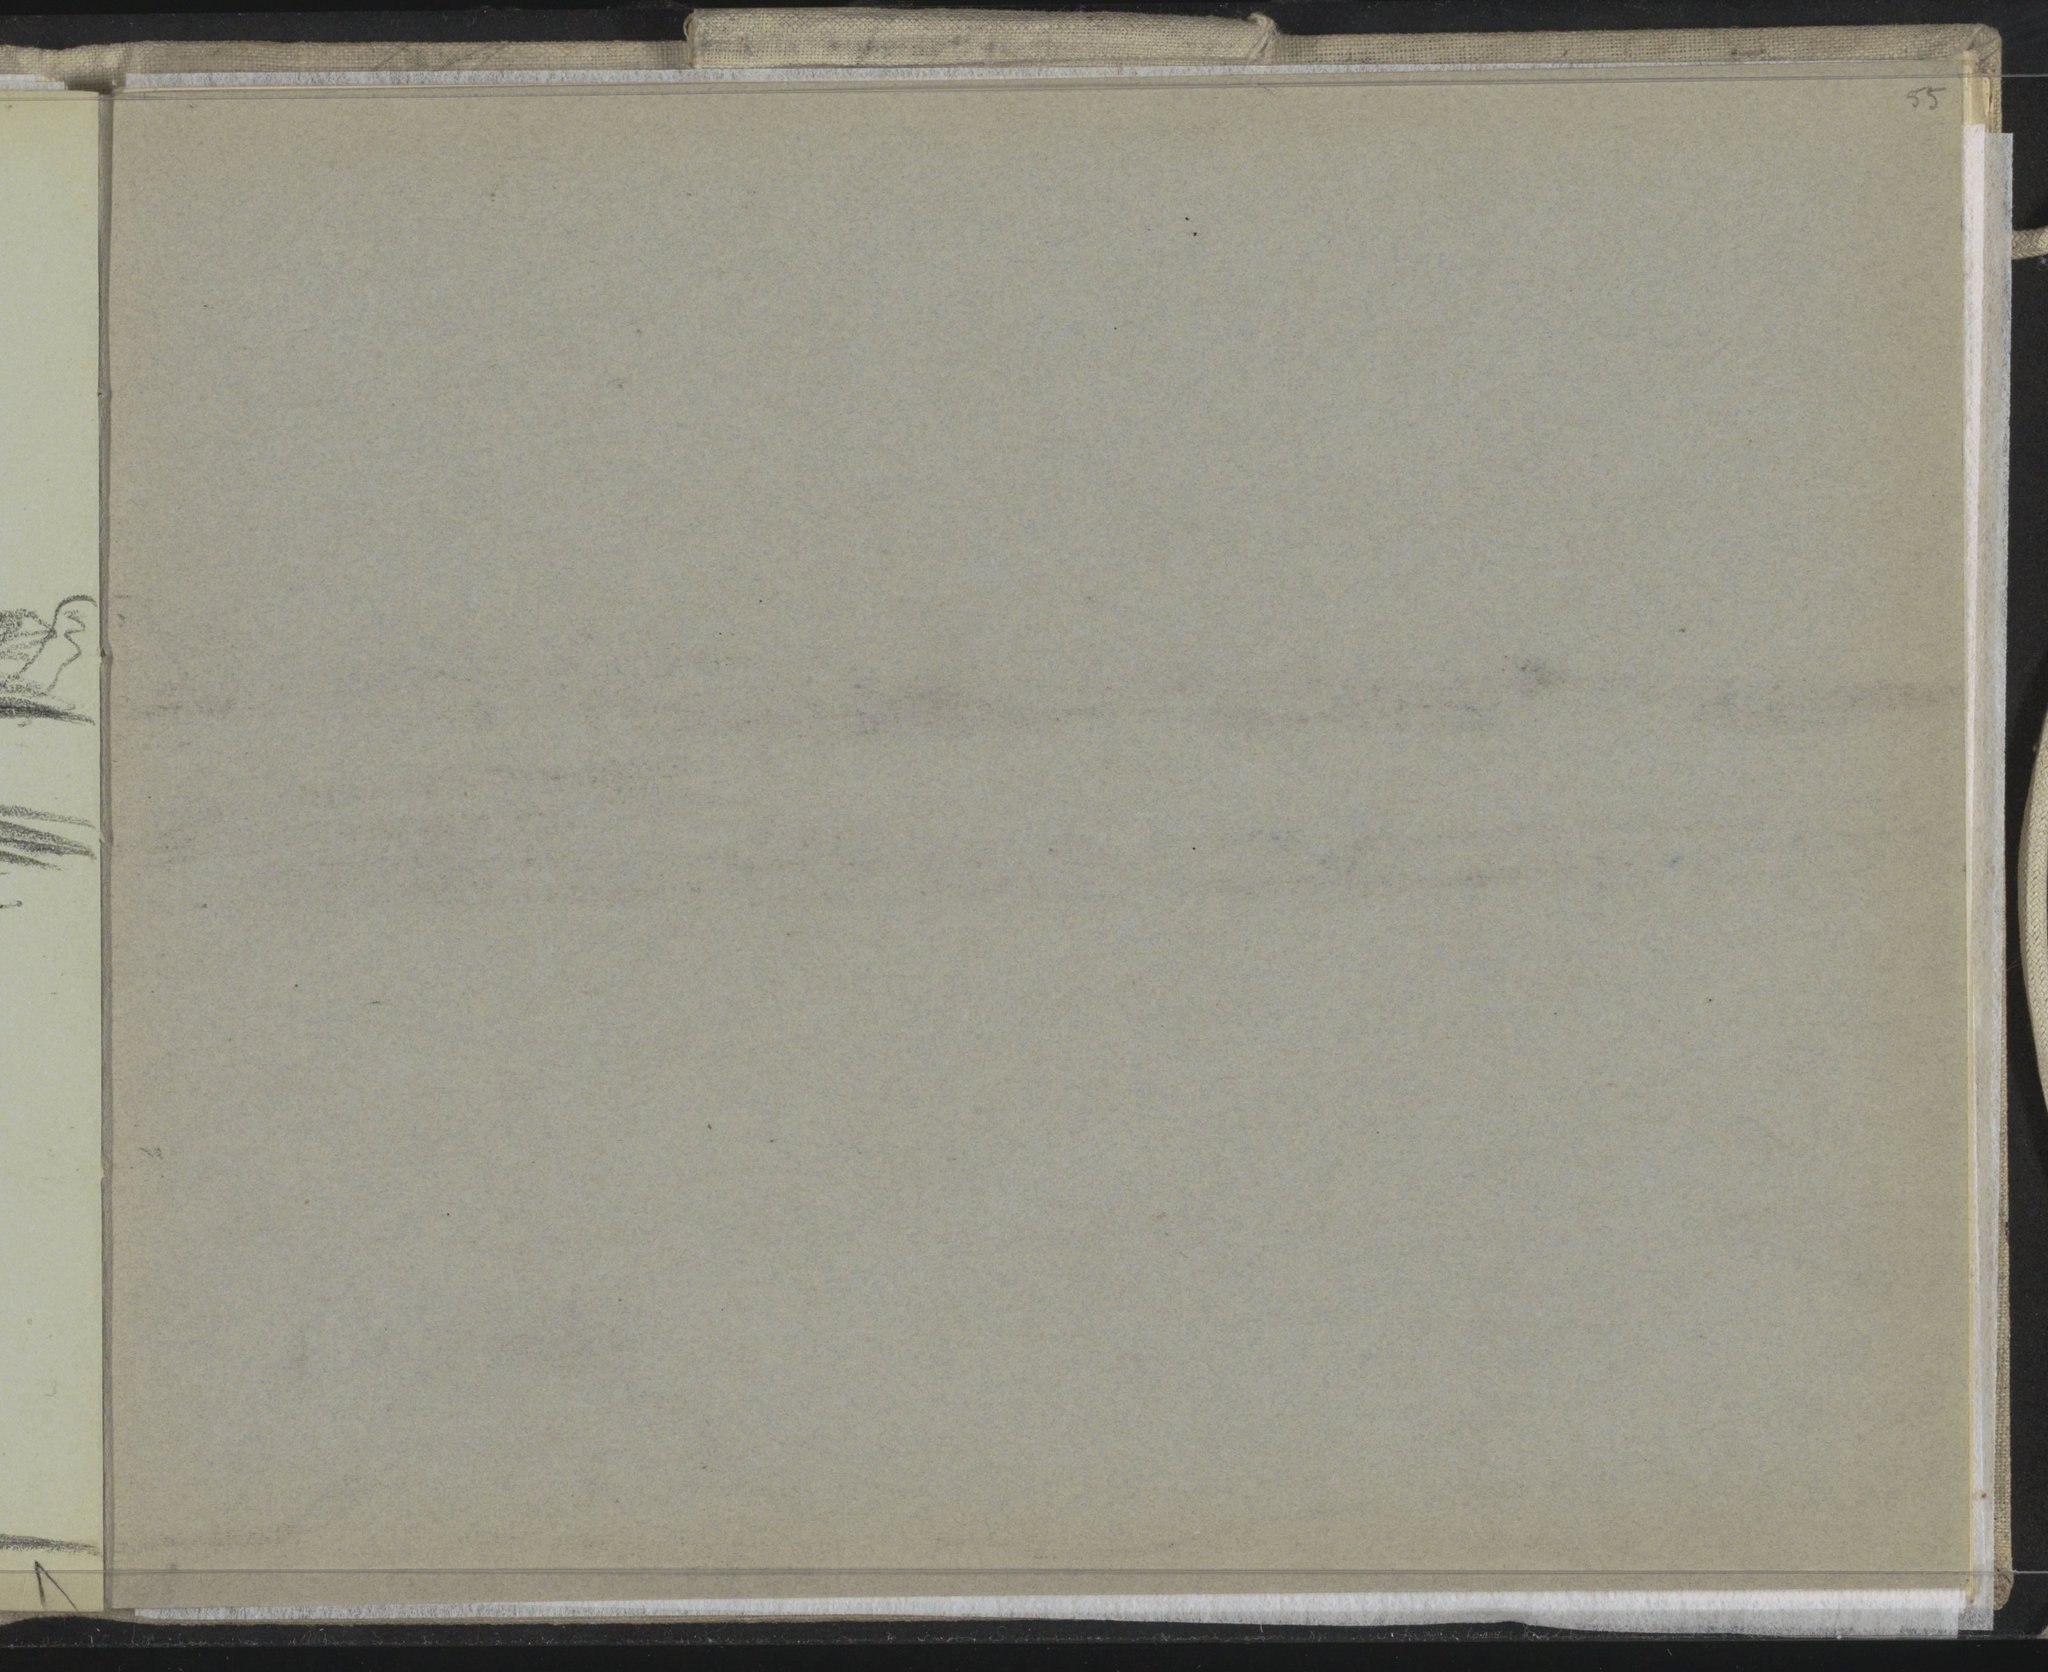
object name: sketchbook leaf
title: Abklatsch van de krijttekening op pagina 54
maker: willem witsen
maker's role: draughtsman, painter, print maker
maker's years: 1860-1923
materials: paper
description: Pagina 55 uit een schetsboek met 43 bladen.